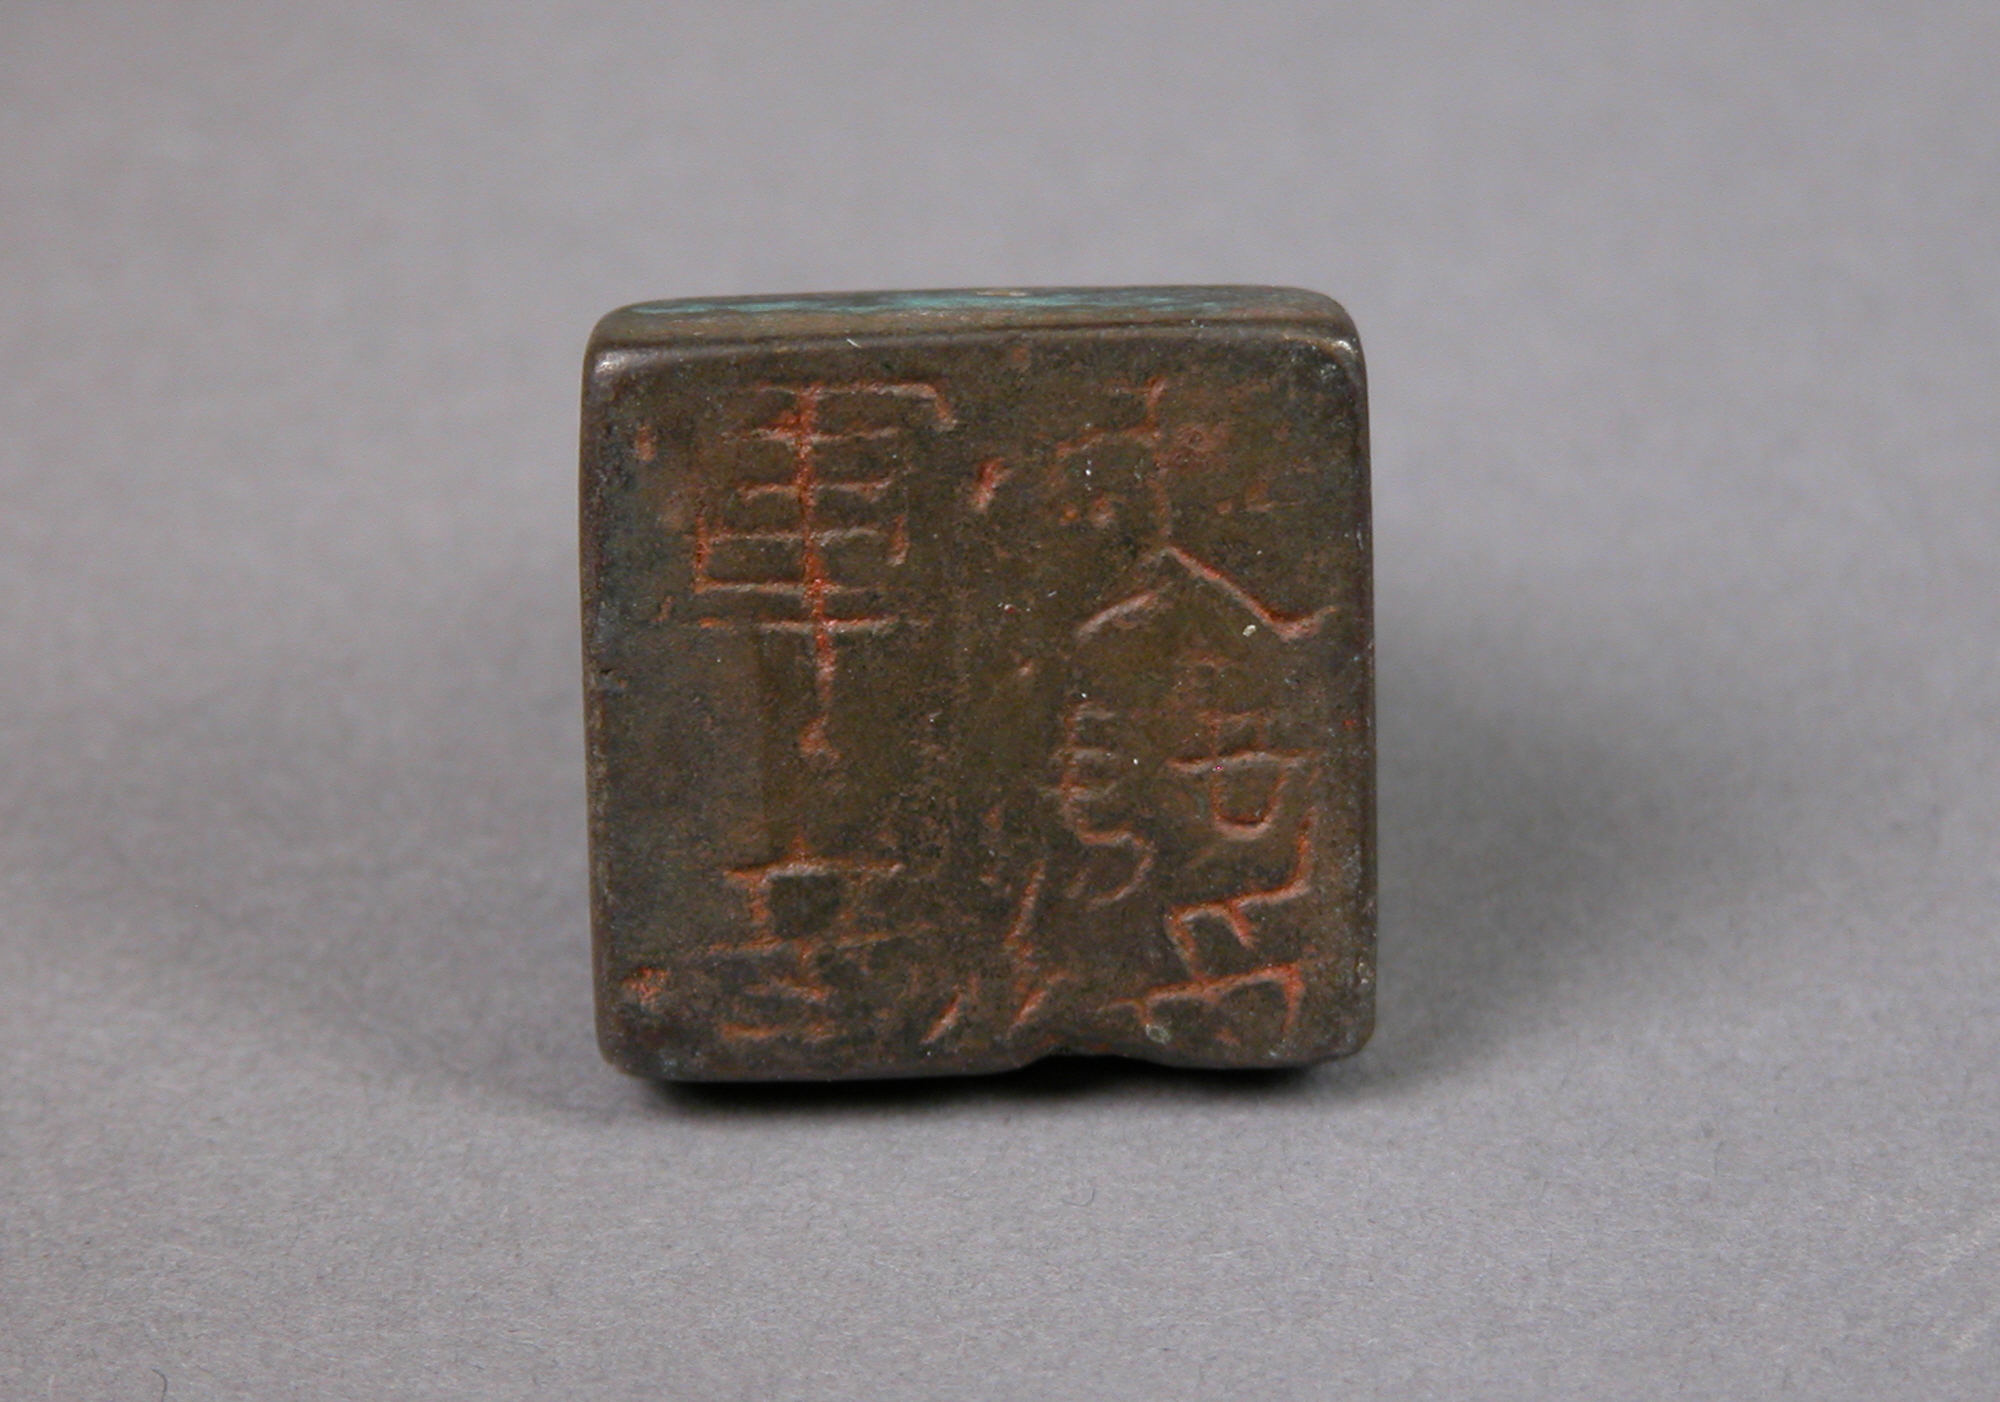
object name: seal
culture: chinese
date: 1300-1644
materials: bronze